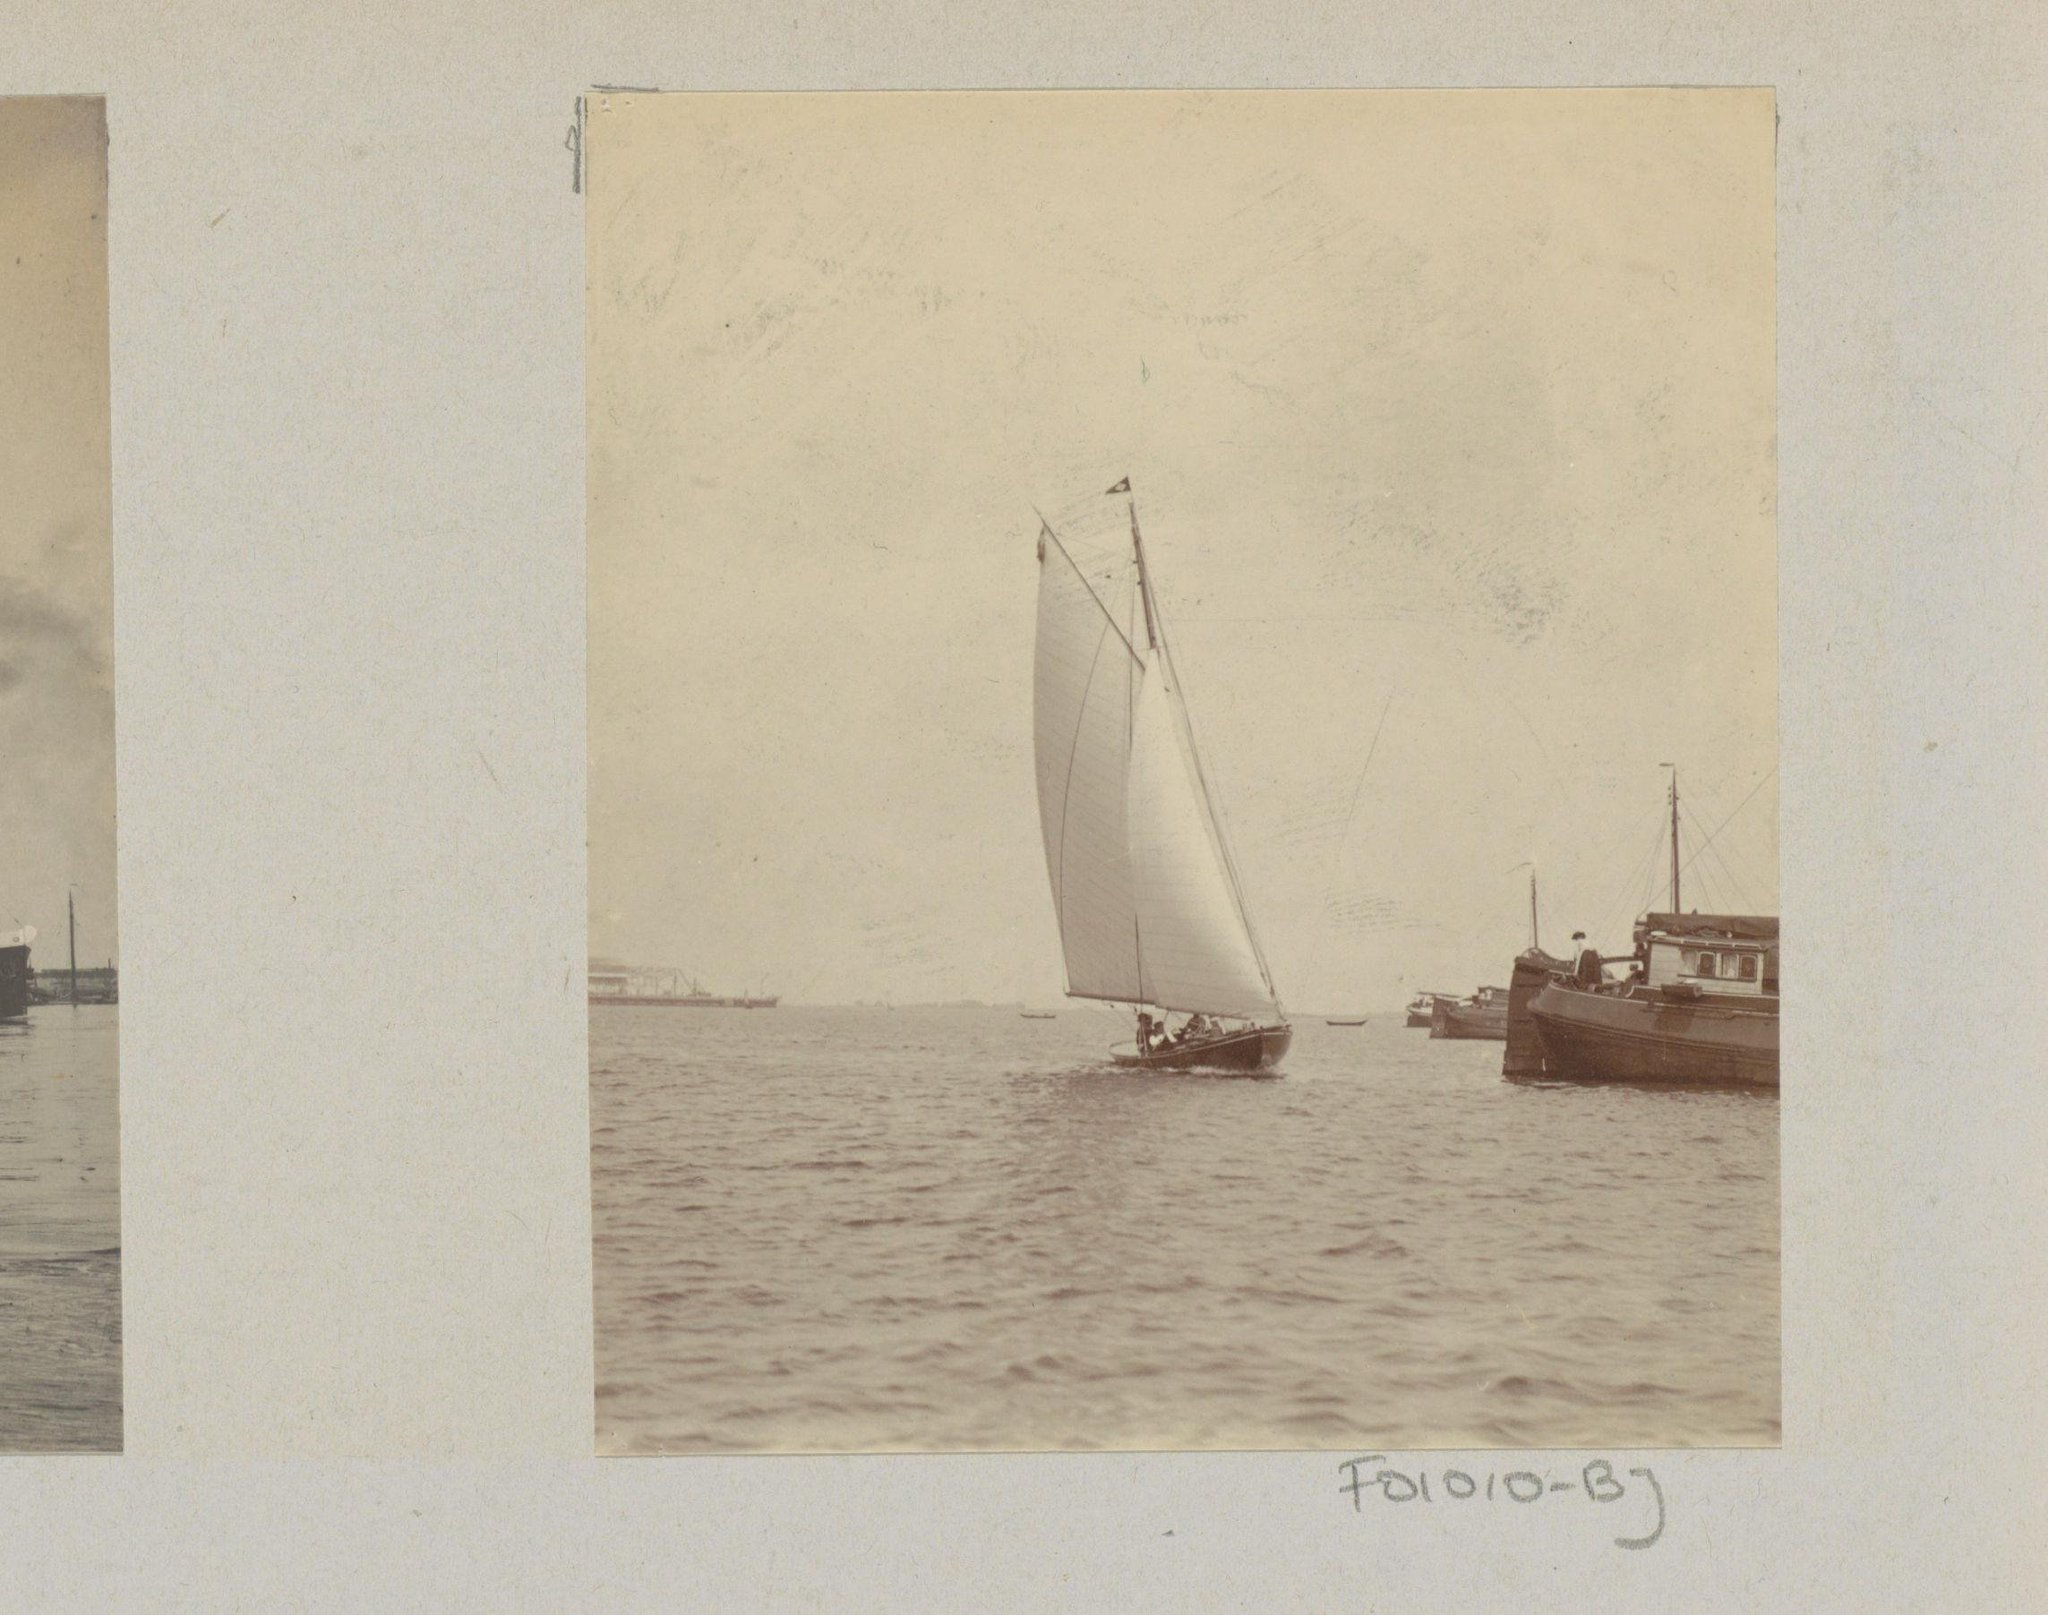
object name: photograph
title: Zeilschip en rijnaak op het water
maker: Anonymous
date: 1900-1910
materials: photographic support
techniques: daylight paper print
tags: sailing-ship, sailing-boat, sea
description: Onderdeel van Familiealbum met onder meer foto's van Wijnhandel Kraaij & Co. Bordeaux-Amsterdam.